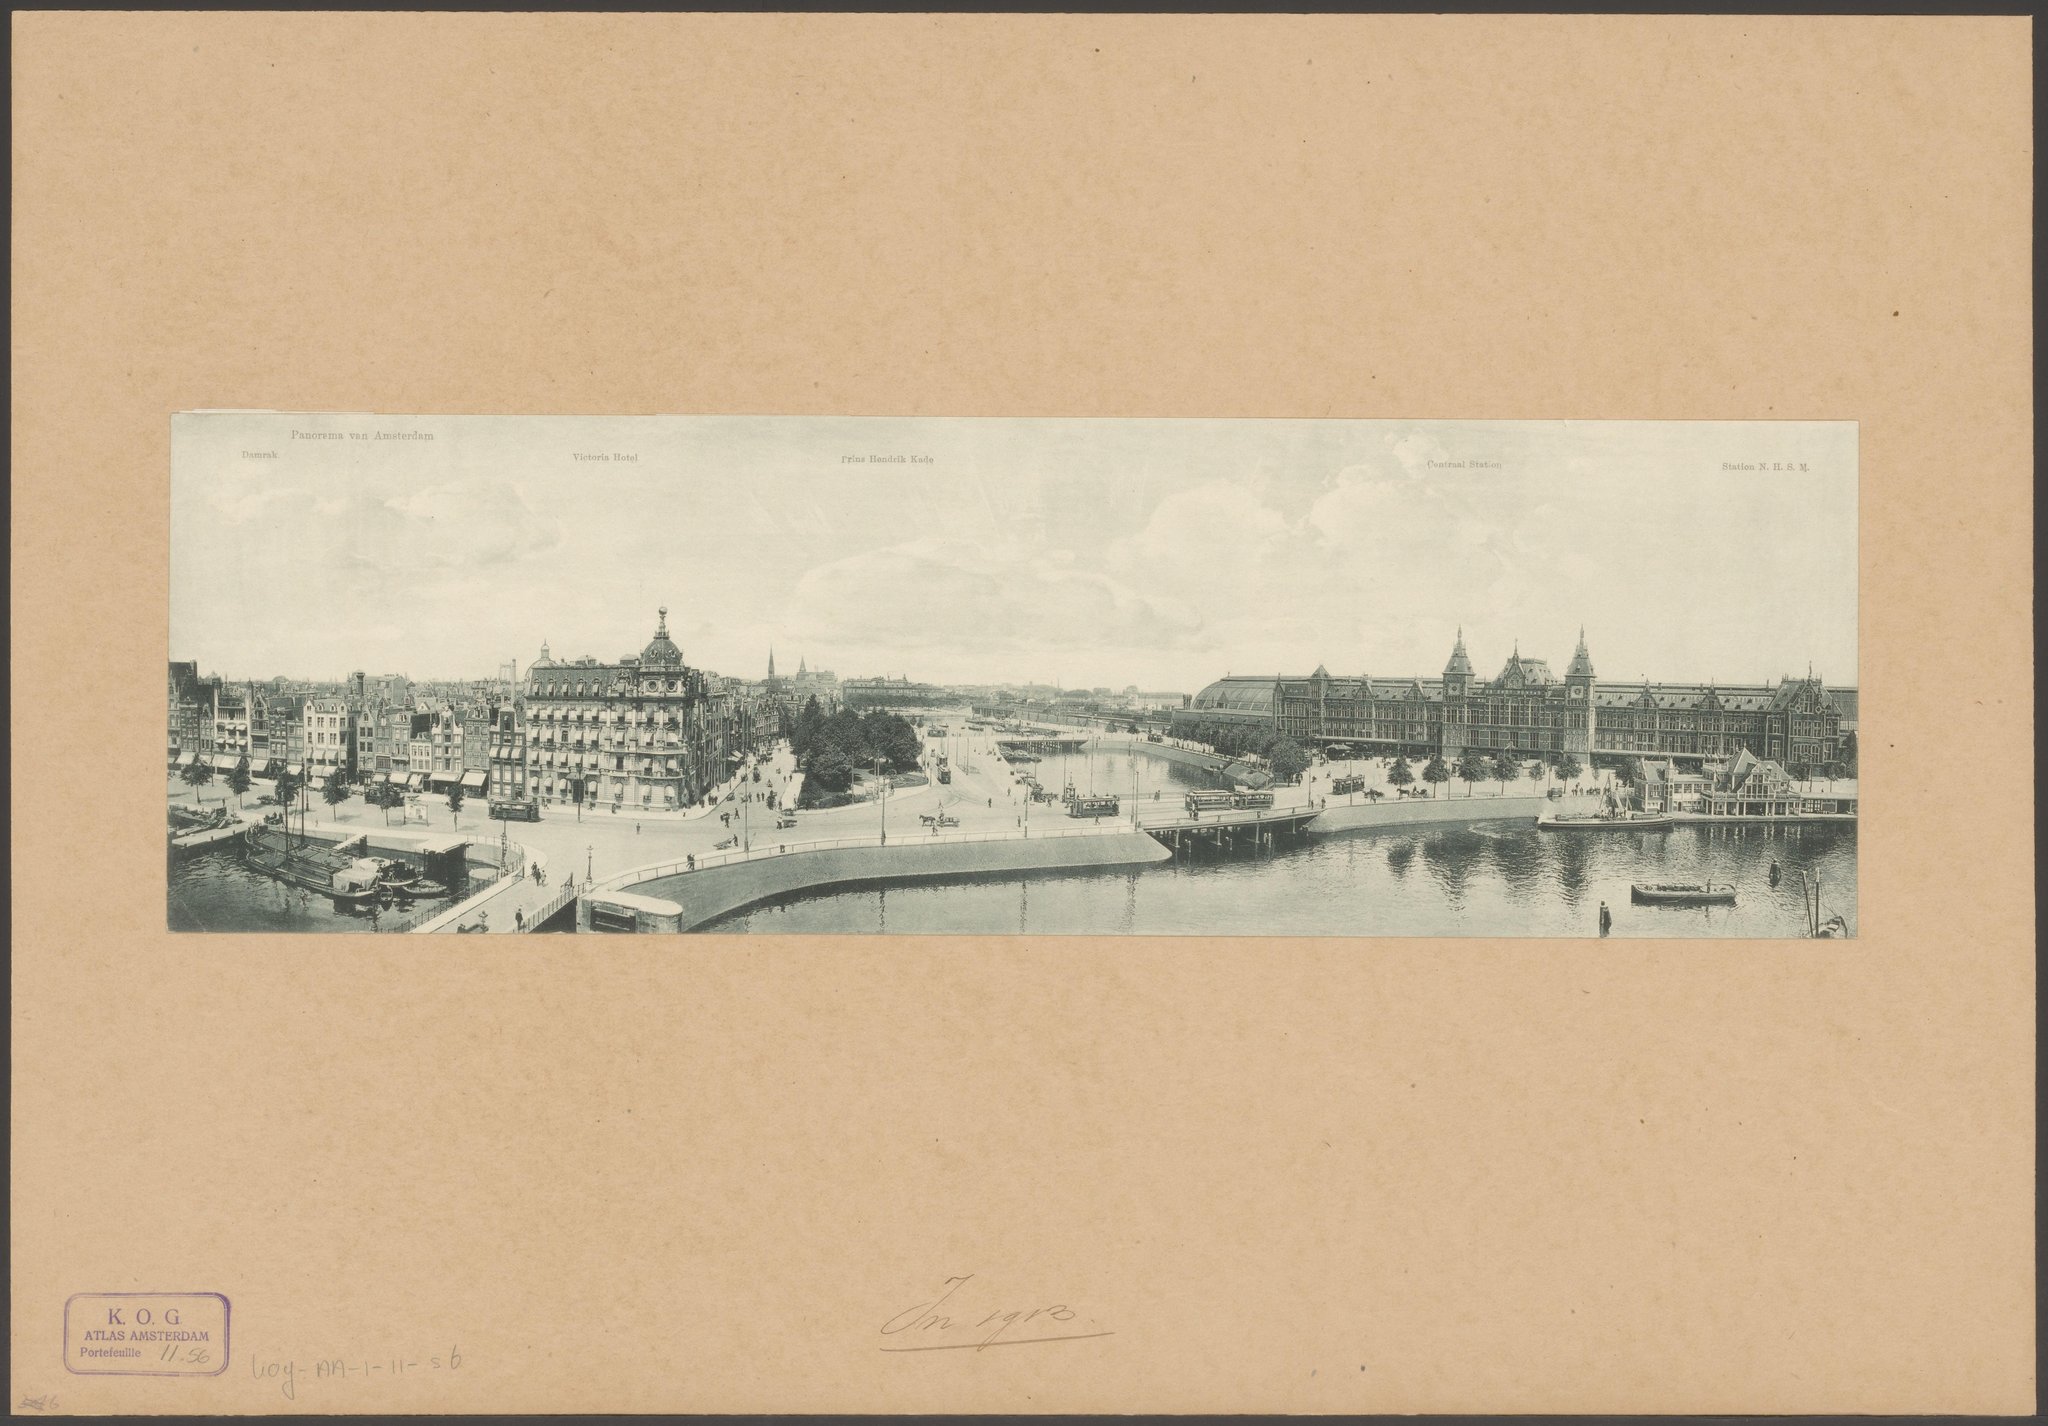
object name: ansichtkaart, prentbriefkaart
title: Panorama van de Prins Hendrikkade en het Damrak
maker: Anonymous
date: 1913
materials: paper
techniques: photograph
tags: city-view in general; 'veduta', station; shelter (railway, tramway), street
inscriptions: date: ‘In 1913’, collector's mark: ‘11.56’ Lugt 1641b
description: Onderwerpsrubriek binnen de Atlas Amsterdam: Prinsengracht, Korte Prinsengracht, Prins Hendrikkade. Zie ook Portefeuille 1: gezichten van het IJ op de stad.